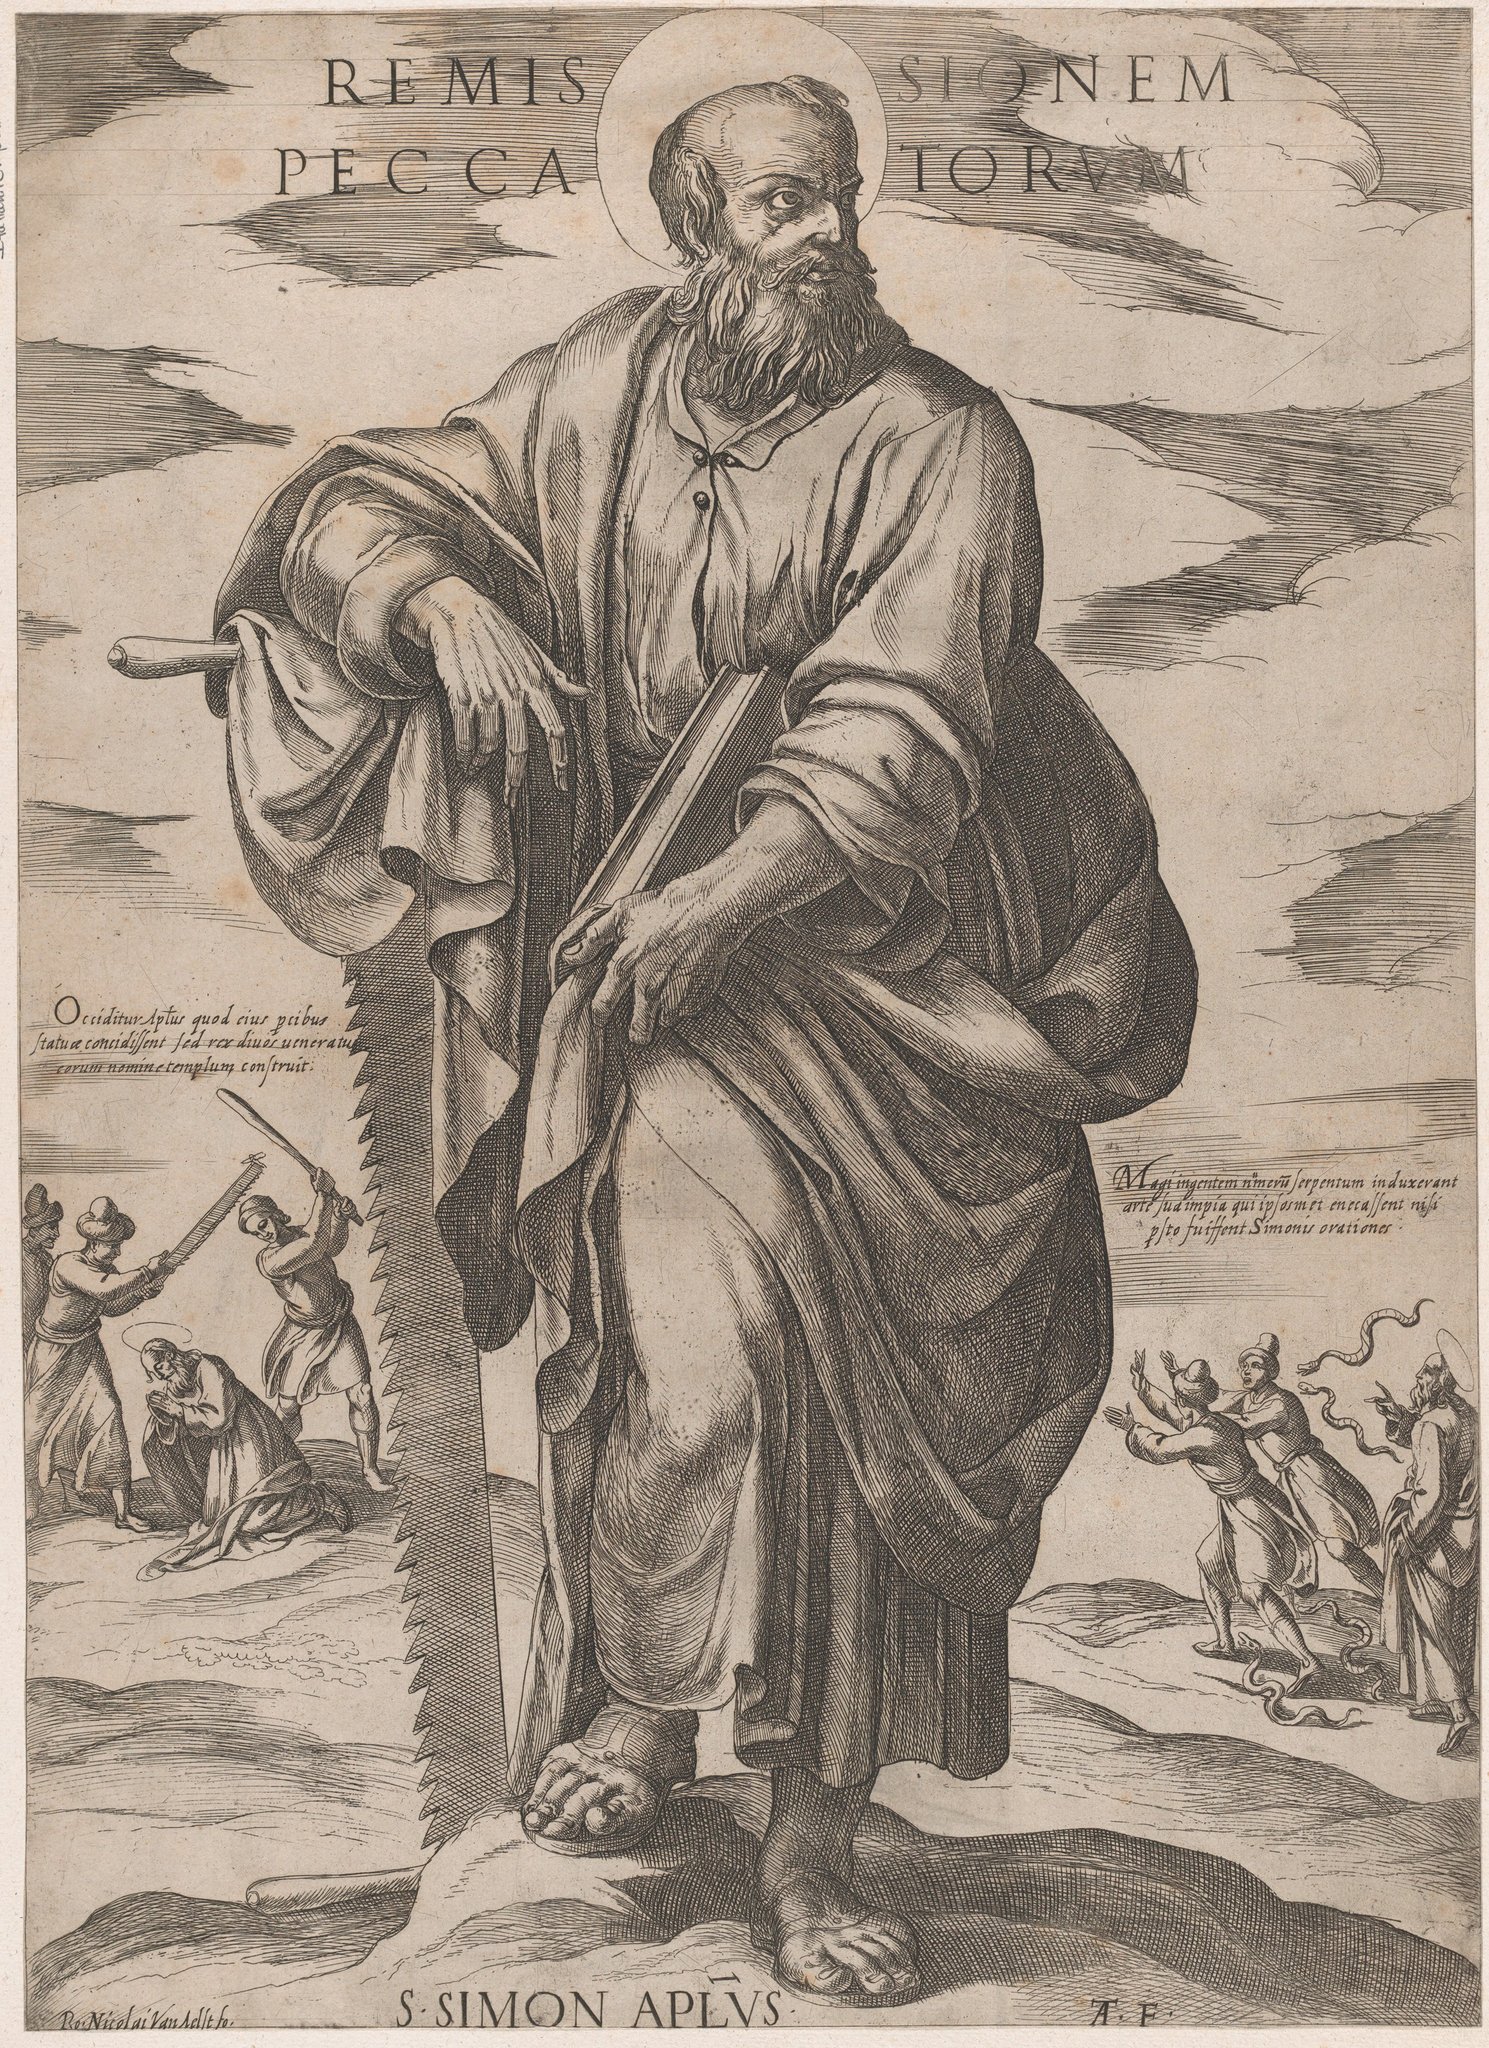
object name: print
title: St. Simon, from 'Christ, Mary, and the Apostles'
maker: antonio tempesta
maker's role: artist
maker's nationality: italian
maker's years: 1555-1630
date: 1590-1610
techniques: etching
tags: saints